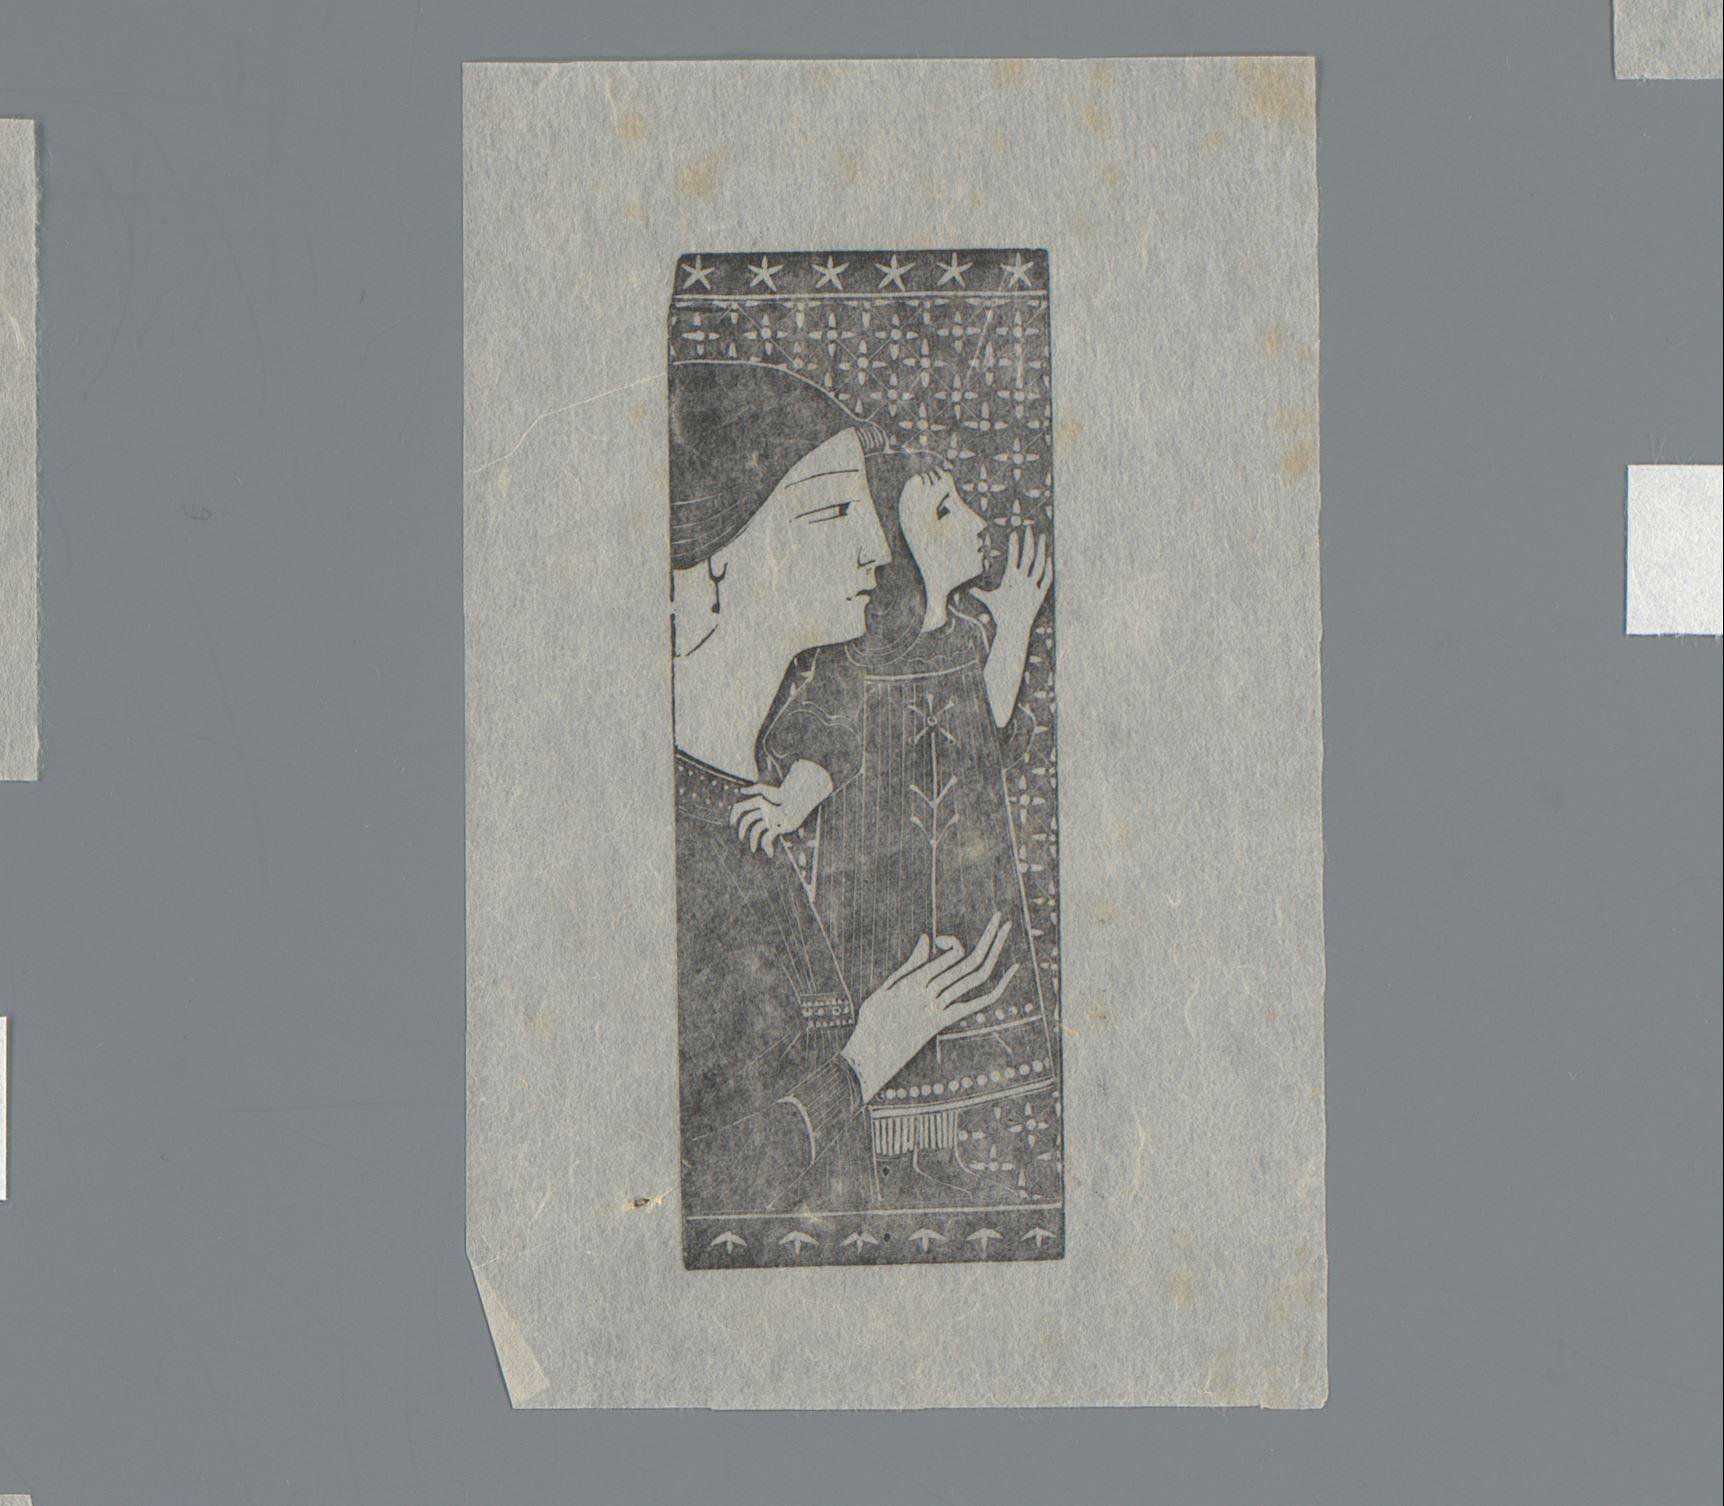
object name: print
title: Moeder en kind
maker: karel petrus cornelis de bazel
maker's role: draughtsman, print maker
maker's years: 1869-1923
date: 1895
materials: paper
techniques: woodcut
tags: mother and baby or young child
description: Deze prent is gebruikt voor: Licht en waarheid. Orgaan van de Vereeniging 'Wie denkt overwint', 23 maart 1895.